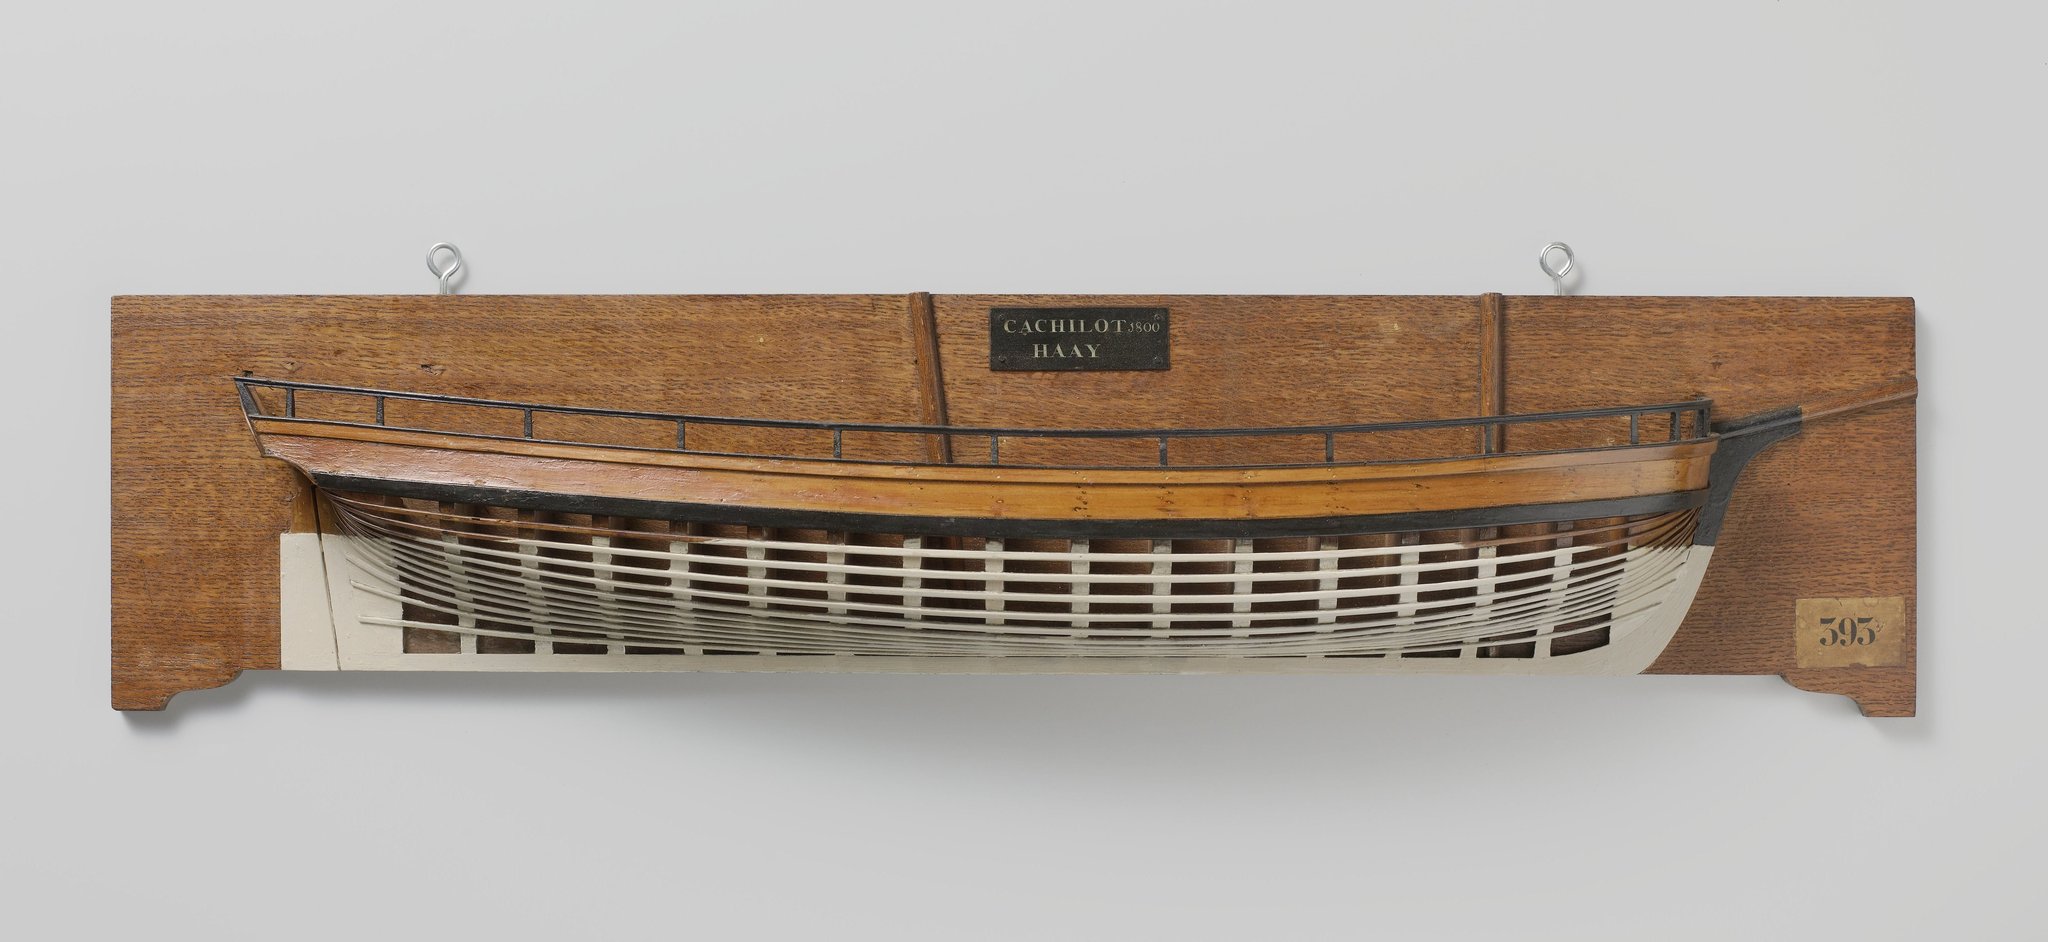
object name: half model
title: Half Model of a 3-Gun Schooner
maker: Anonymous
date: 1800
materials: wood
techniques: polychromy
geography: rotterdam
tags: cachelot (schip), haai (schip)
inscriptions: label, bottom right: ‘393’ former inventory label, inscription, top centre, on a rectangular black label: ‘CACHILOT 1800 / HAAY’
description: Gepolychromeerd mallenmodel (stuurboord) van een tweemaster. De huid boven het barkhout is gesloten, het schip heeft een reling. Gewrongen spiegel, hol wulf, geen details van het hek, geen zijgalerij, sterk vallende achtersteven; recht roer met vierkante roerkoning. Zeeg naar beide einden oplopend, één barkhout en één reehout. Gepiekt rondspant. De grote mast helt naar achter, de fokkemast staat bijna verticaal.